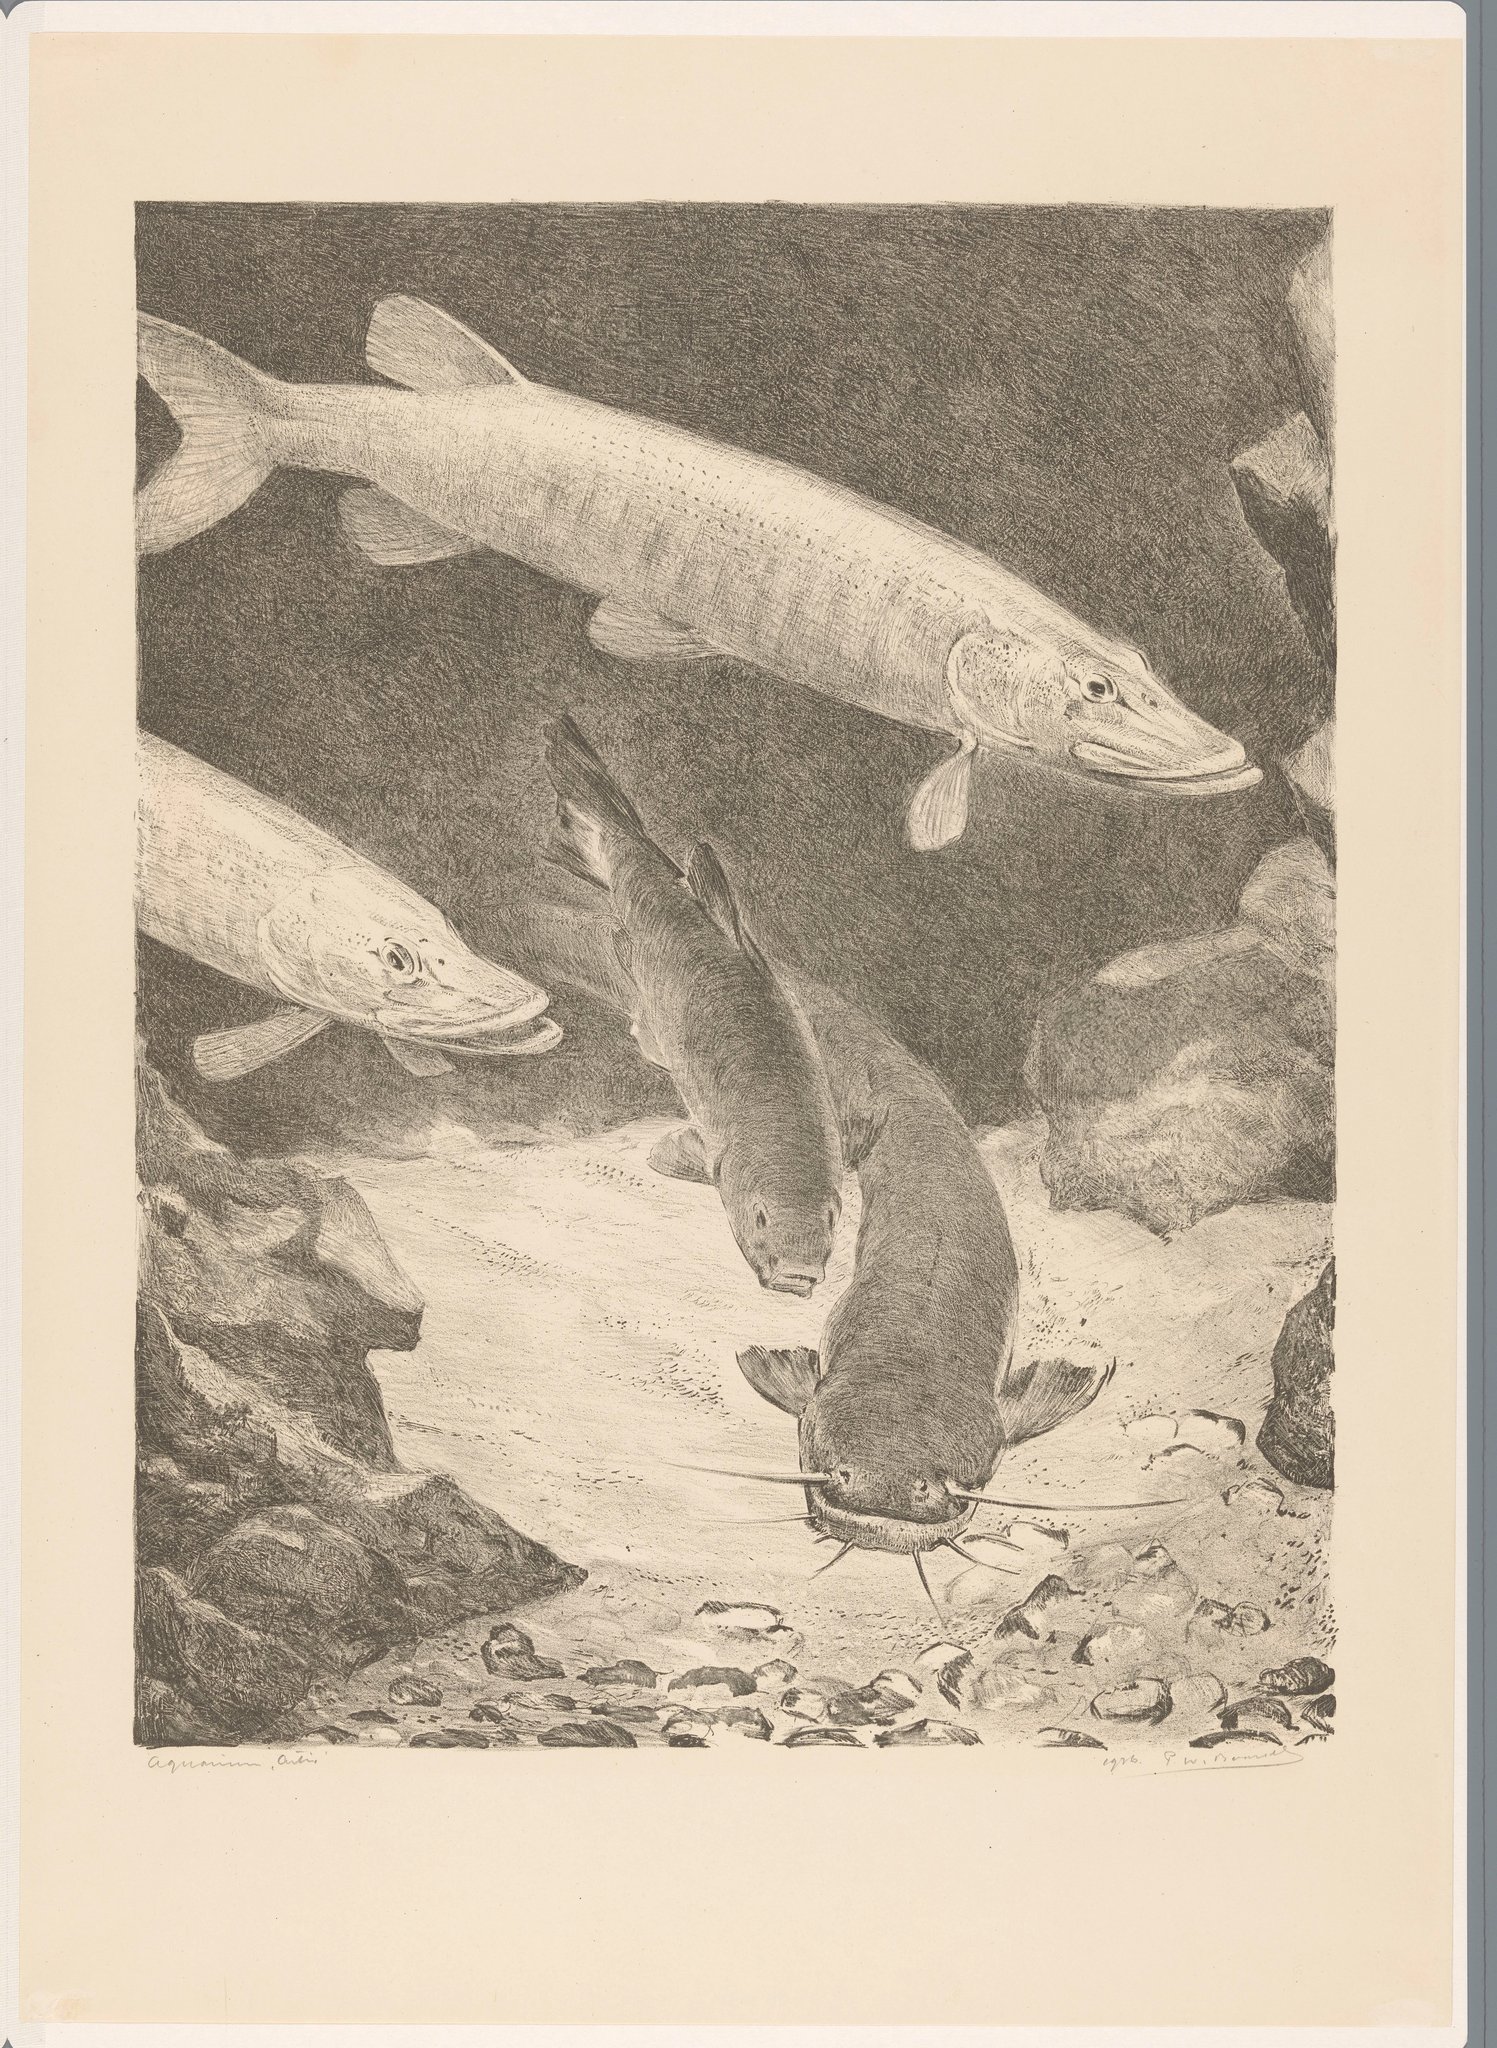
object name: print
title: Portret van Philipp Cluver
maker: de passe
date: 1625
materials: paper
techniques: engraving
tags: danzig, professor, philipp clüver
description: Prent ook gebruikt als boekillustratie in: Meursius, Joannes. Athenæ Batavæ. Sive, De vrbe Leidensi, & academiâ, virisque claris. Leiden: Andries Clouck, Bonaventura en Abraham Elzevier, 1625.